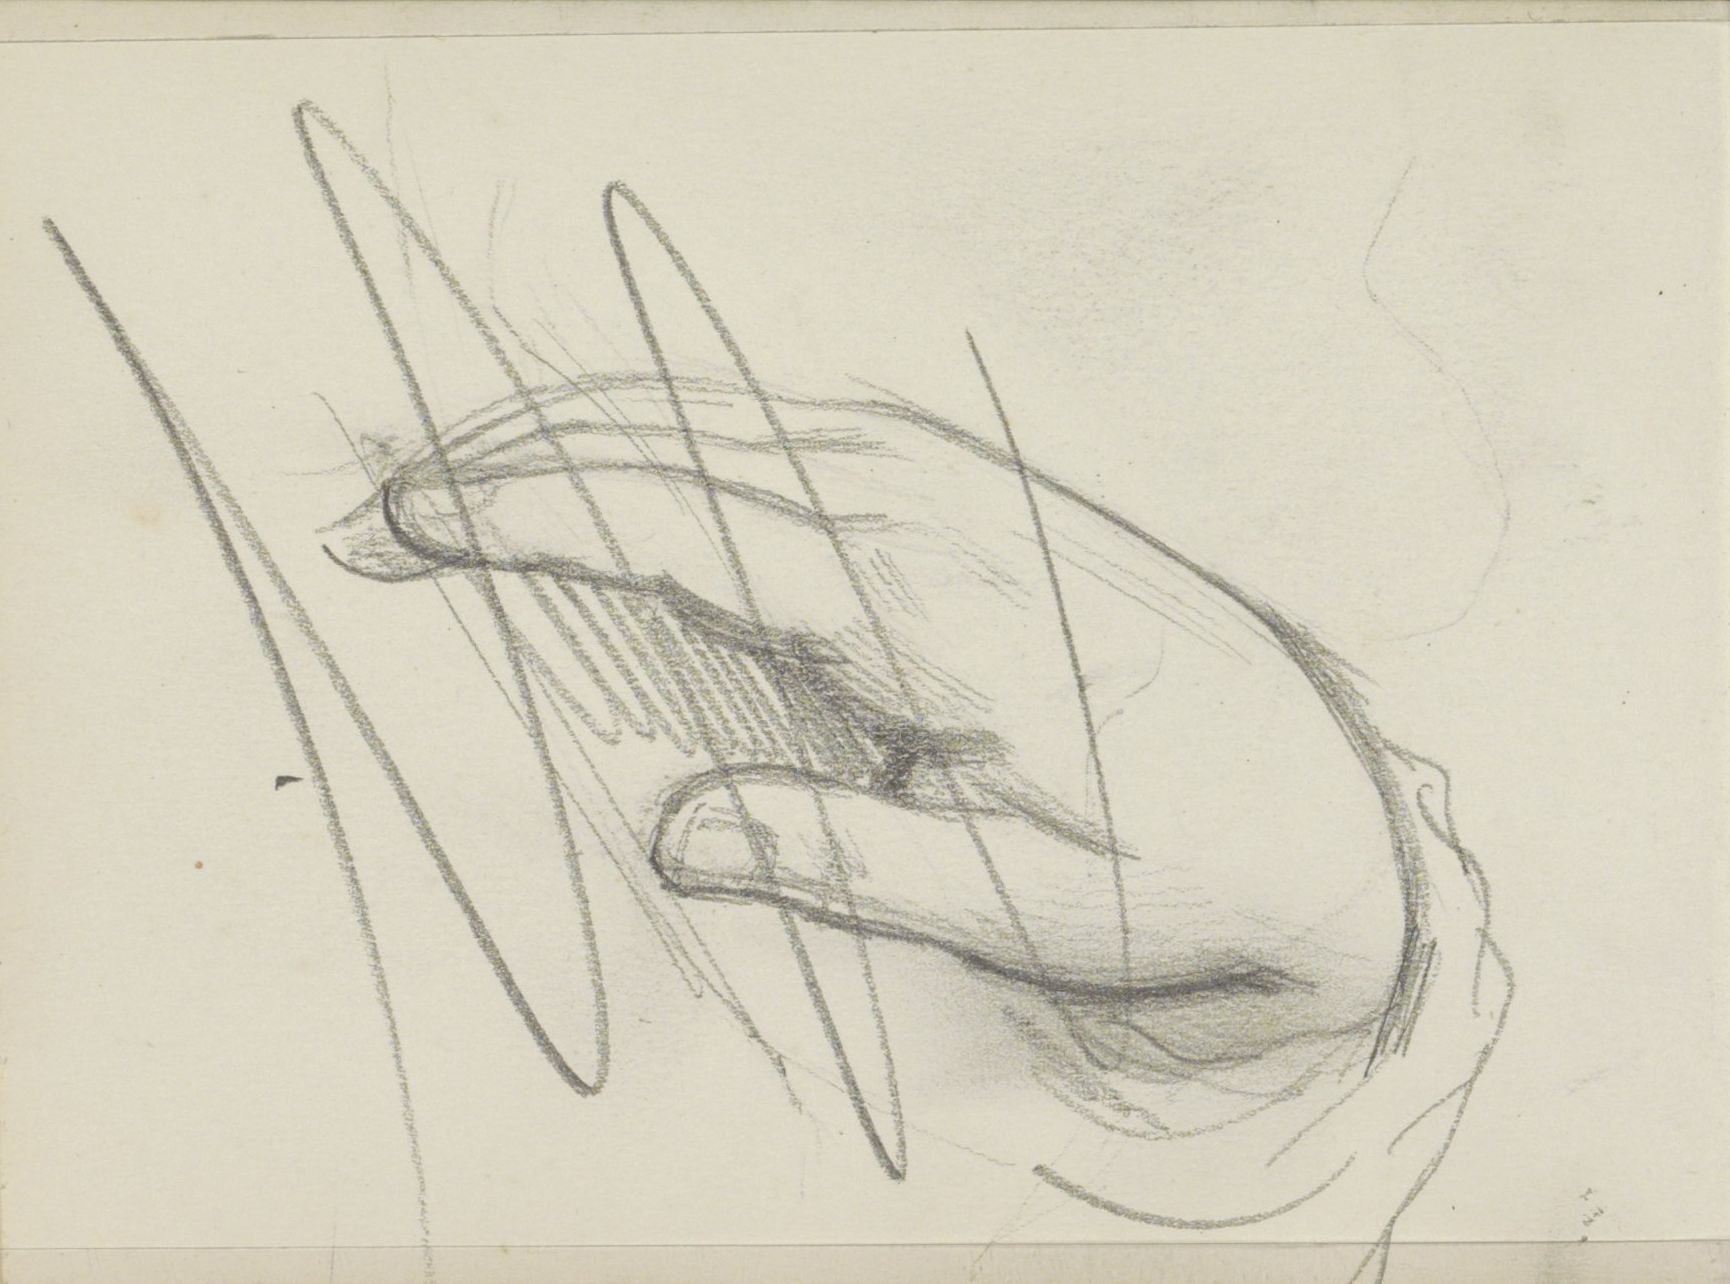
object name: sketchbook leaf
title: Rechterhand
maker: a.a.l. de grammont-hubrecht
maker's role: draughtsman, painter, print maker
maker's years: 1855-1913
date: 1865-1913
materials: paper, pencil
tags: hand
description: De schets is doorgekrast. Blad 31 verso uit een schetsboek met 38 bladen.